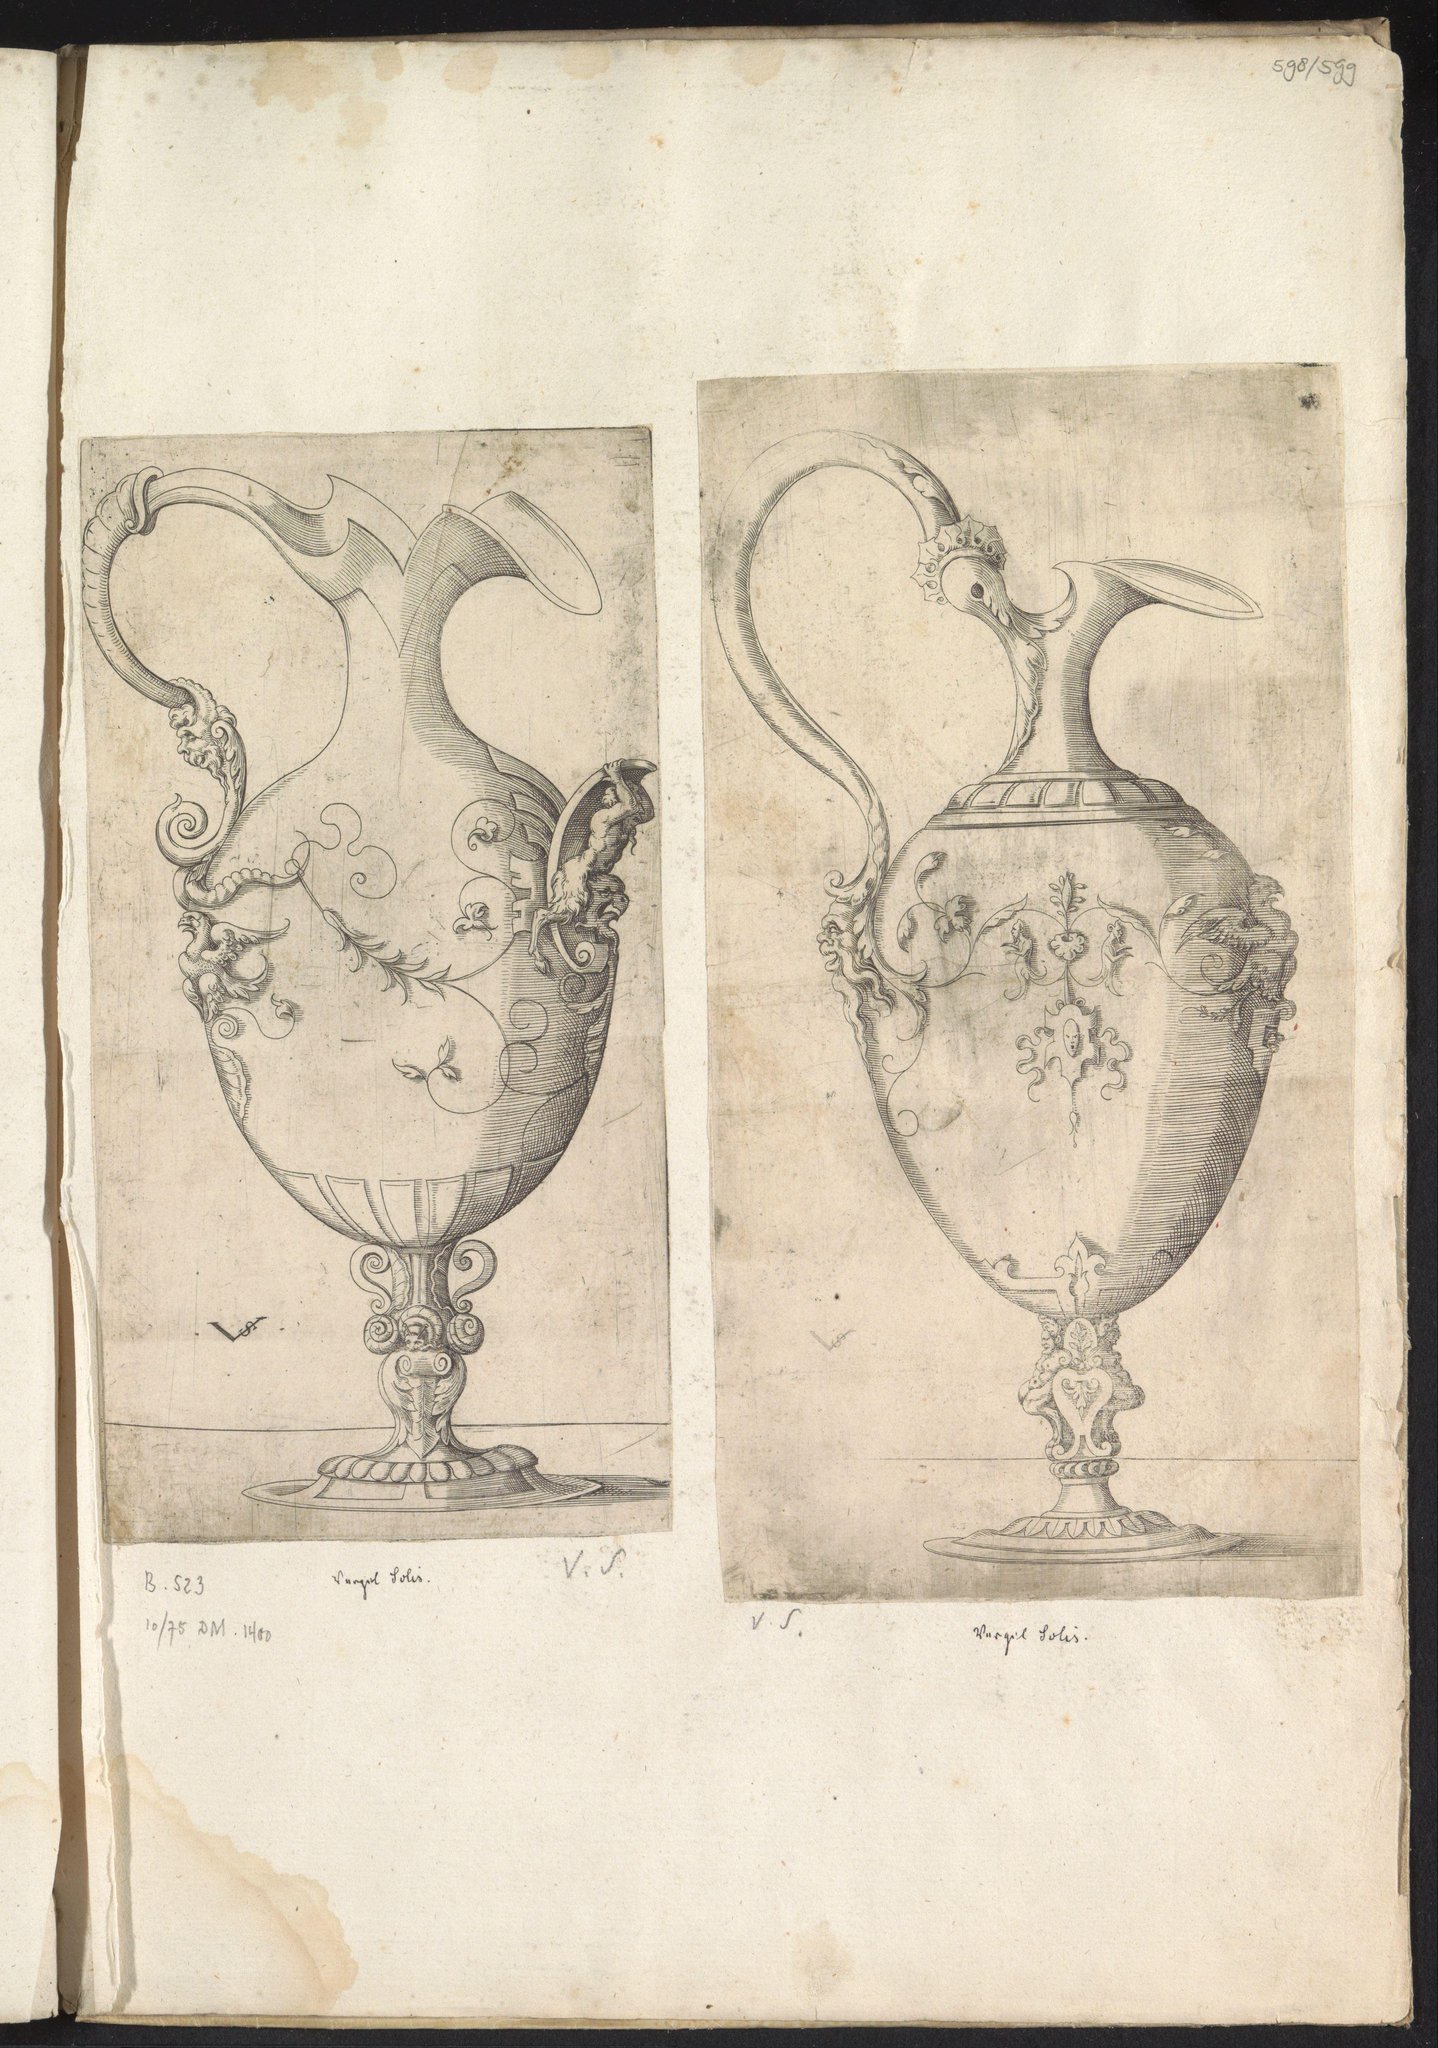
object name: ornament print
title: Albumblad met twee prenten van ornamentele kannen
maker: virgilius solis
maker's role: draughtsman, print maker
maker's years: 1514-1562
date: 1524-1562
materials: paper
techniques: engraving, etching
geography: germany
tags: kitchen-utensils: cauldron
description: Albumblad met twee uitgeknipte prenten van ornamentele kannen.